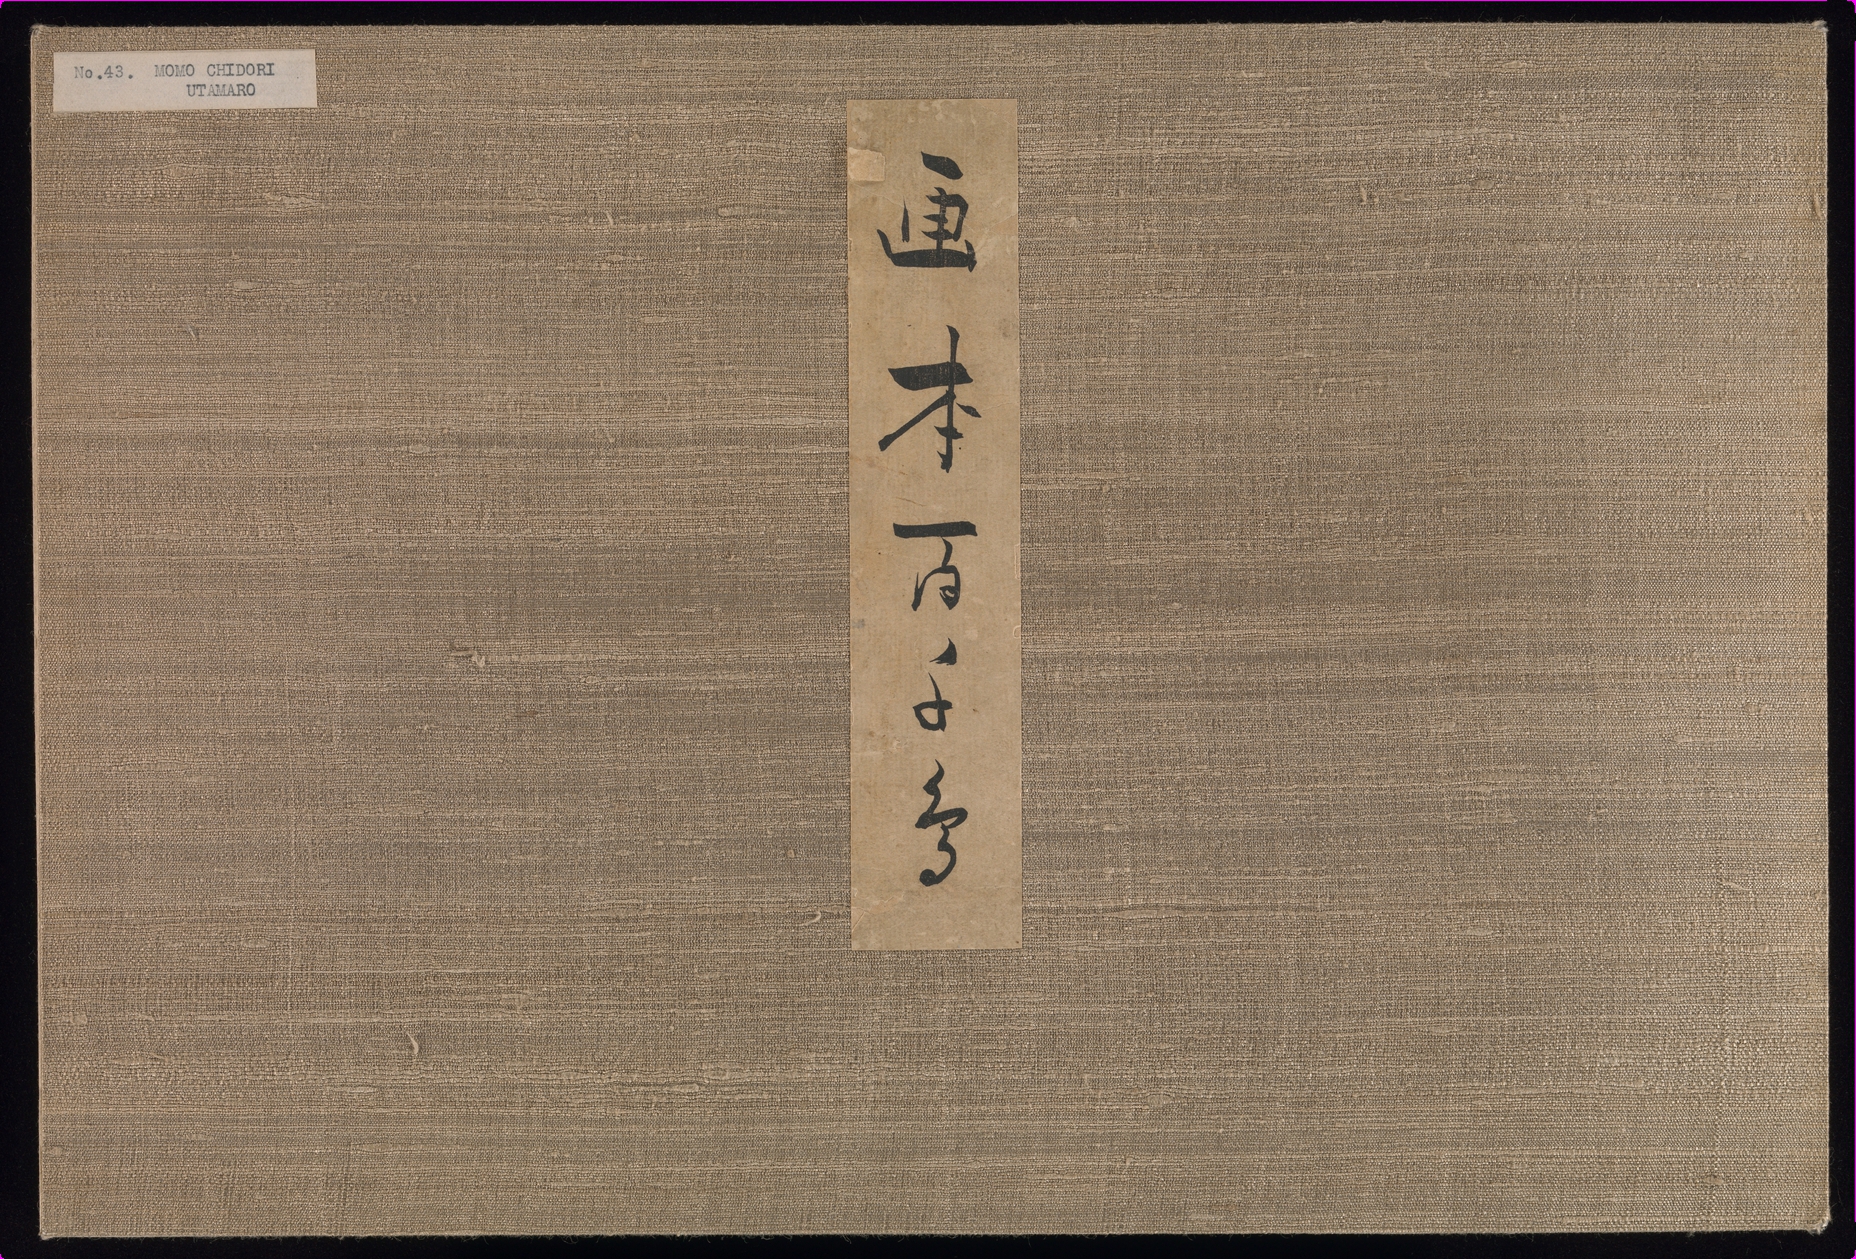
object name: illustrated book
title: Myriad Birds: Picture Book of Playful Verse (Momo chidori kyōka-awase)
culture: japanese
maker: kitagawa utamaro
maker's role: artist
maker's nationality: japanese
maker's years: 1754-1806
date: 1791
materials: ink, paper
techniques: woodblock print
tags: birds